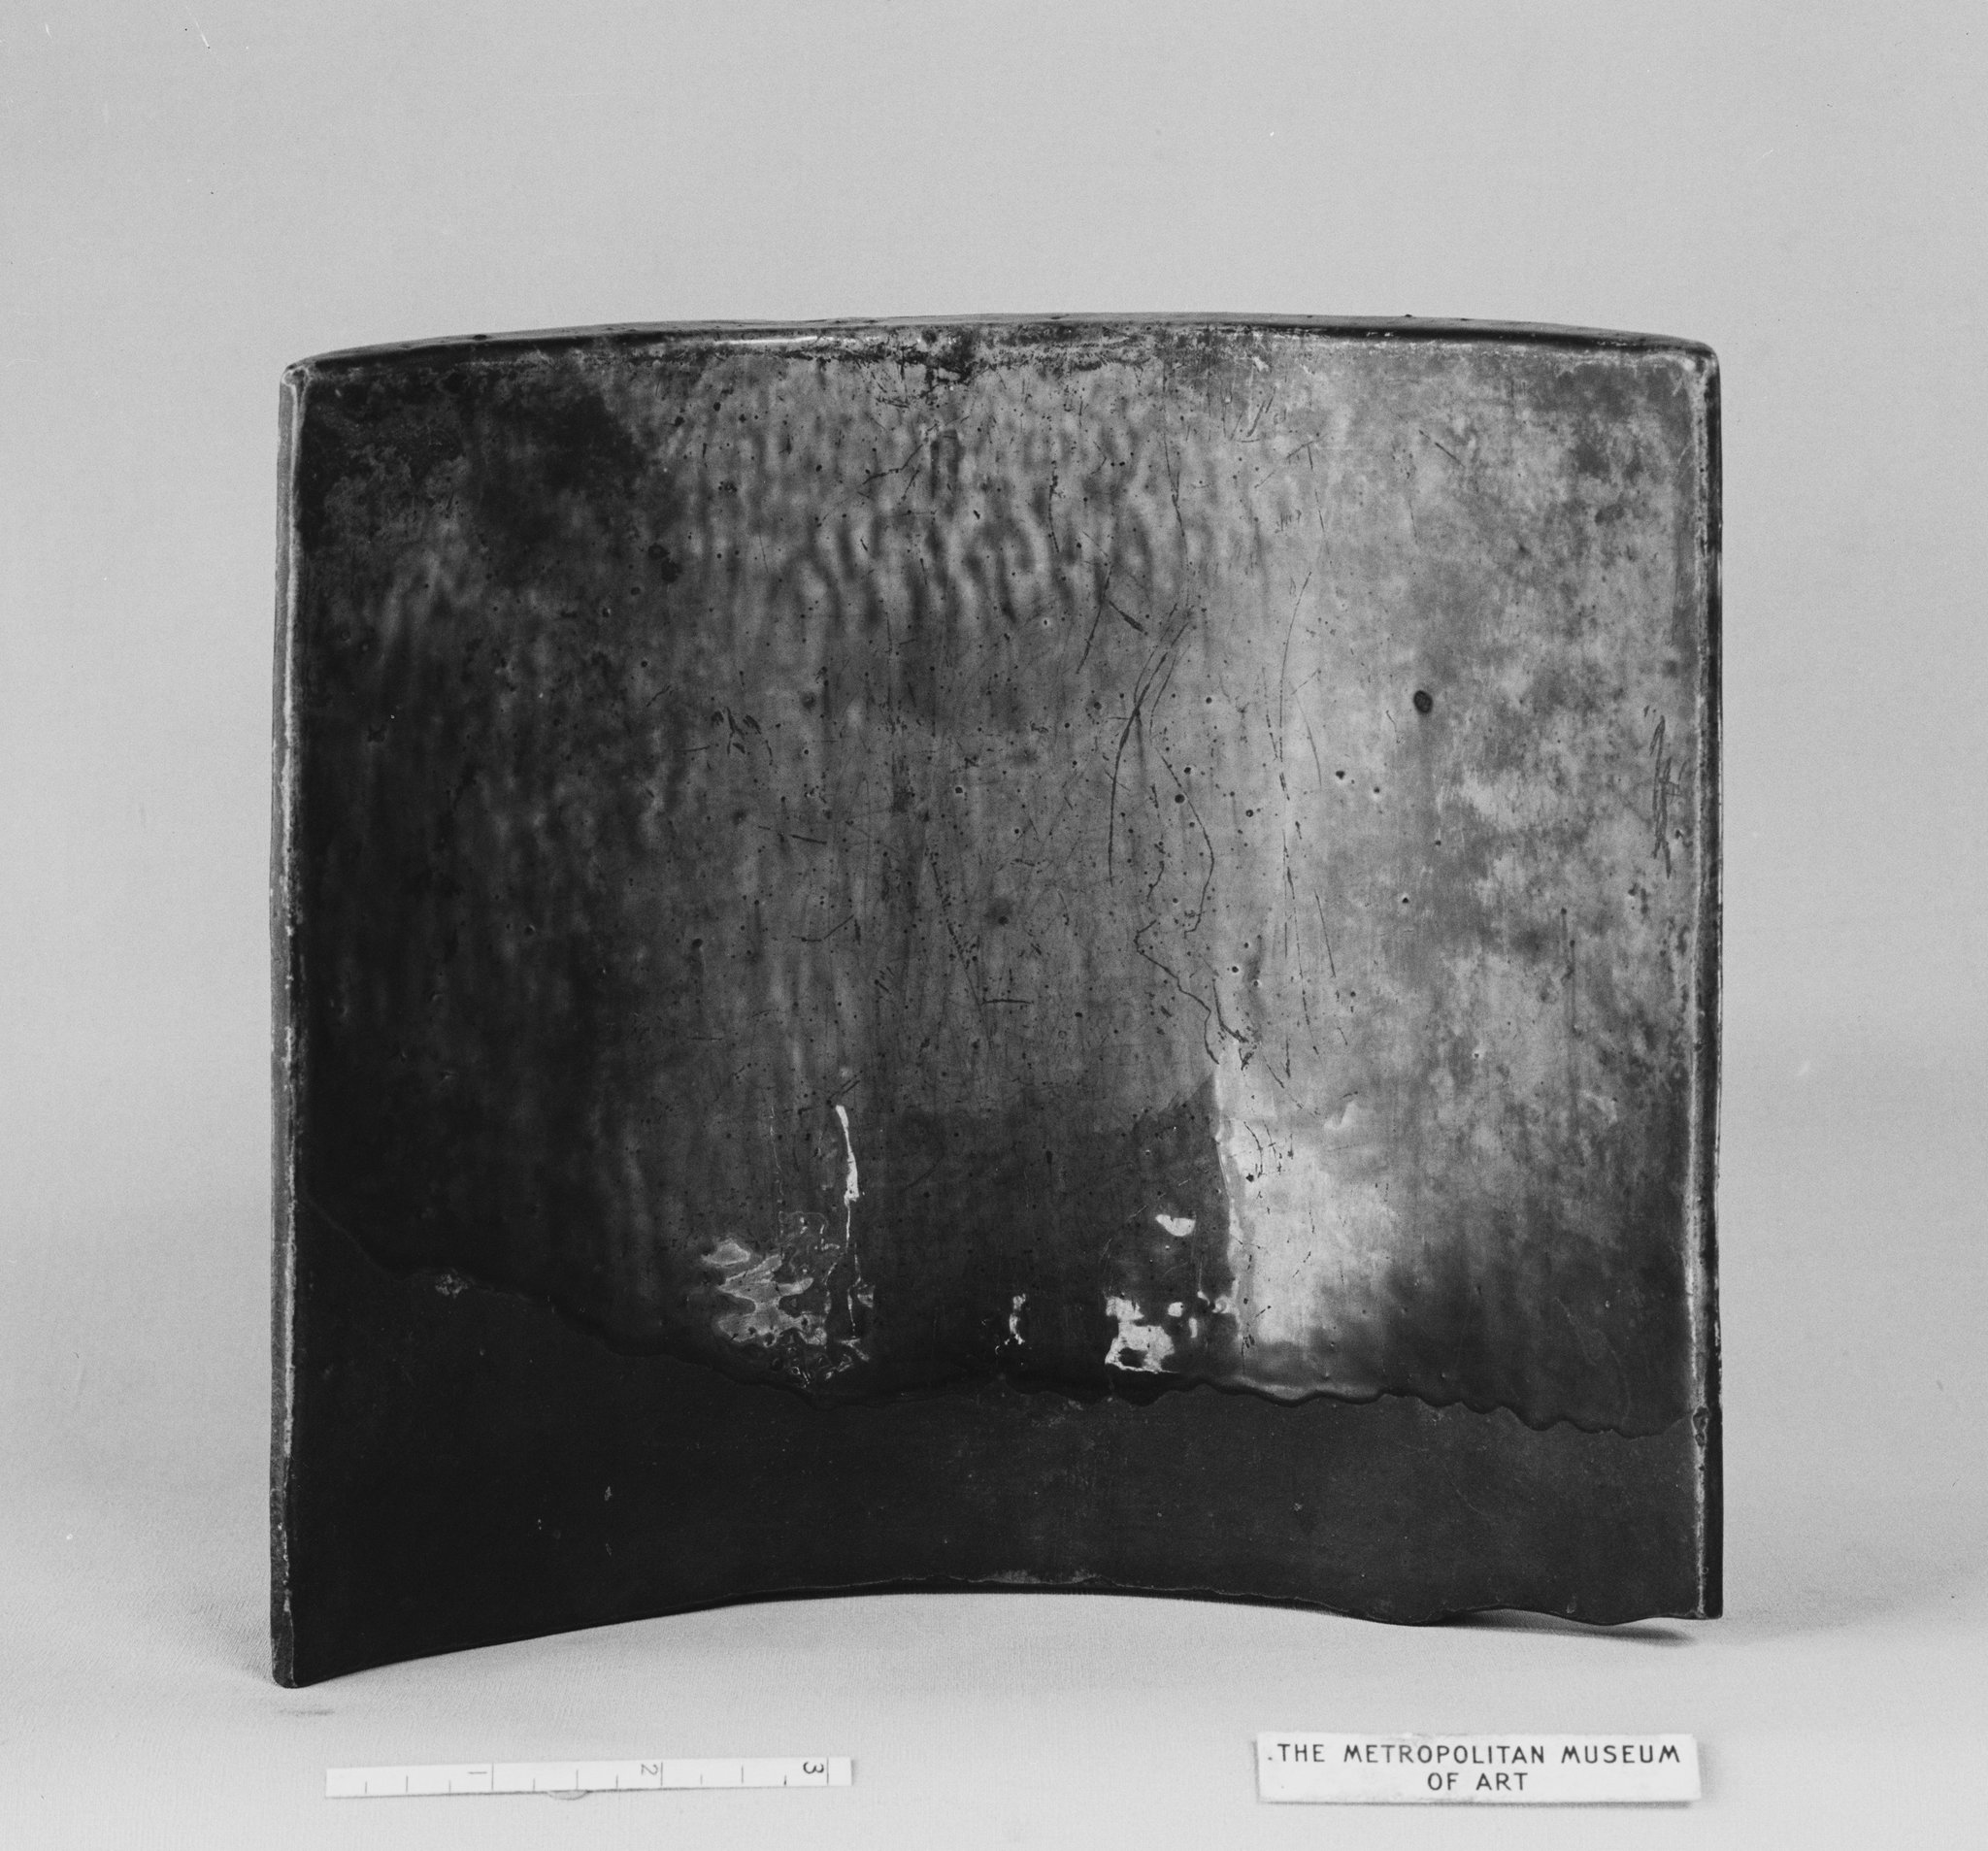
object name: tile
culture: japanese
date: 1701-1800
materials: clay, glaze